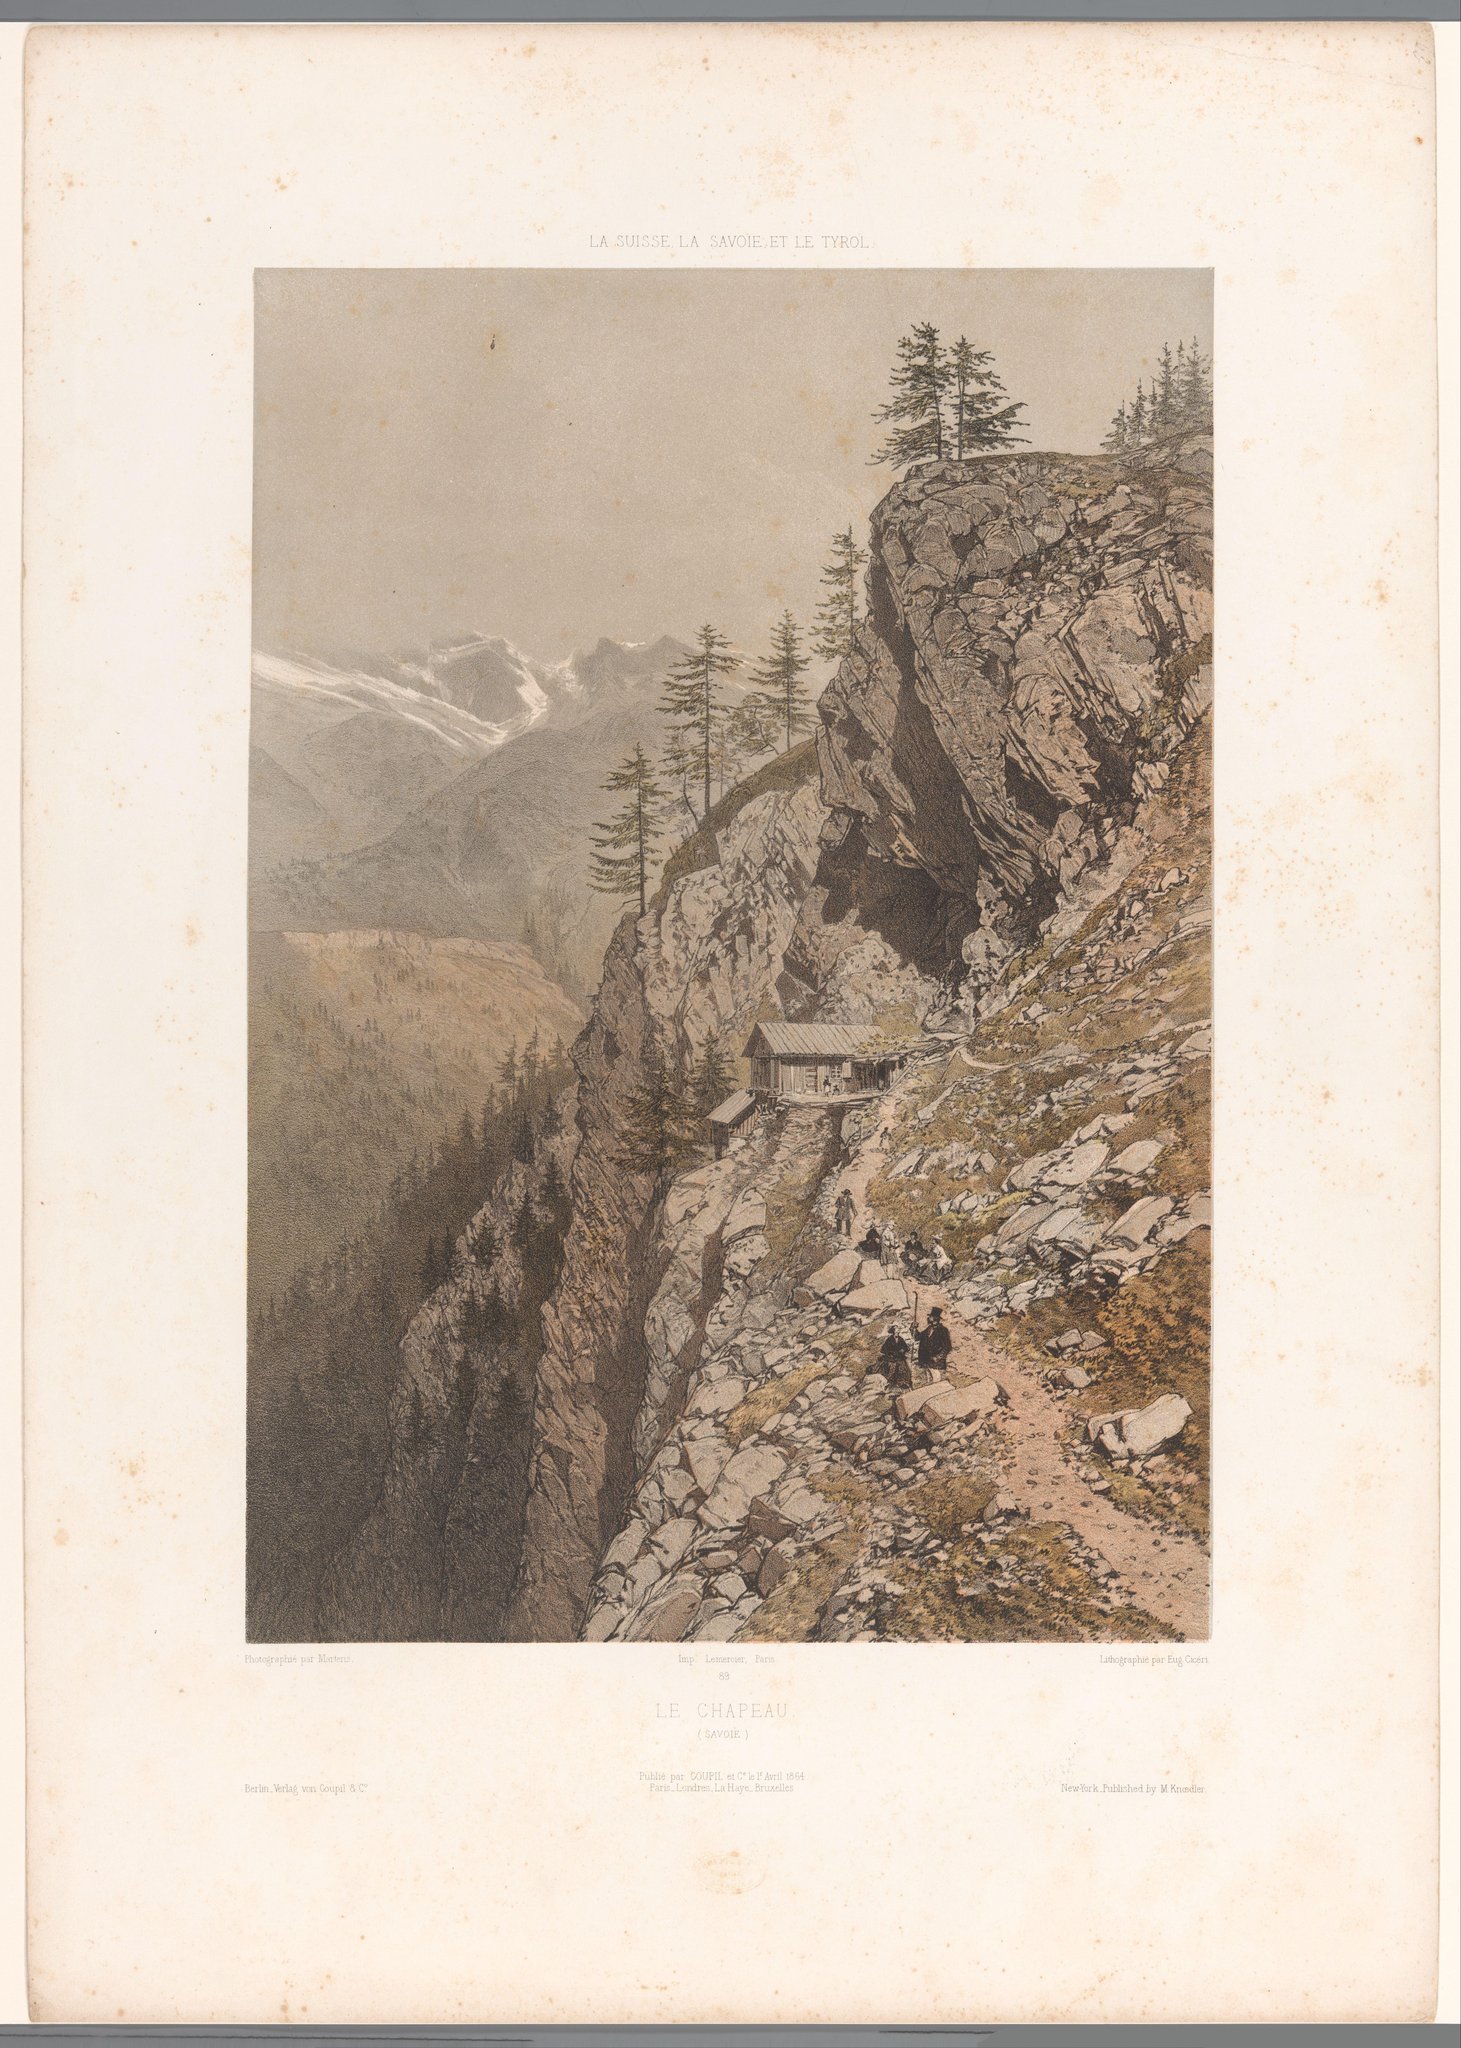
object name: print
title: La Suisse, la Savoie et le Tyrol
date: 1859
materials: paper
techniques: lithograph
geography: paris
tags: mountain-range, snow peaks (+ landscape with figures, staffage), road, path, hut, cabin, lodge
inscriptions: check stamp: Lugt 1090